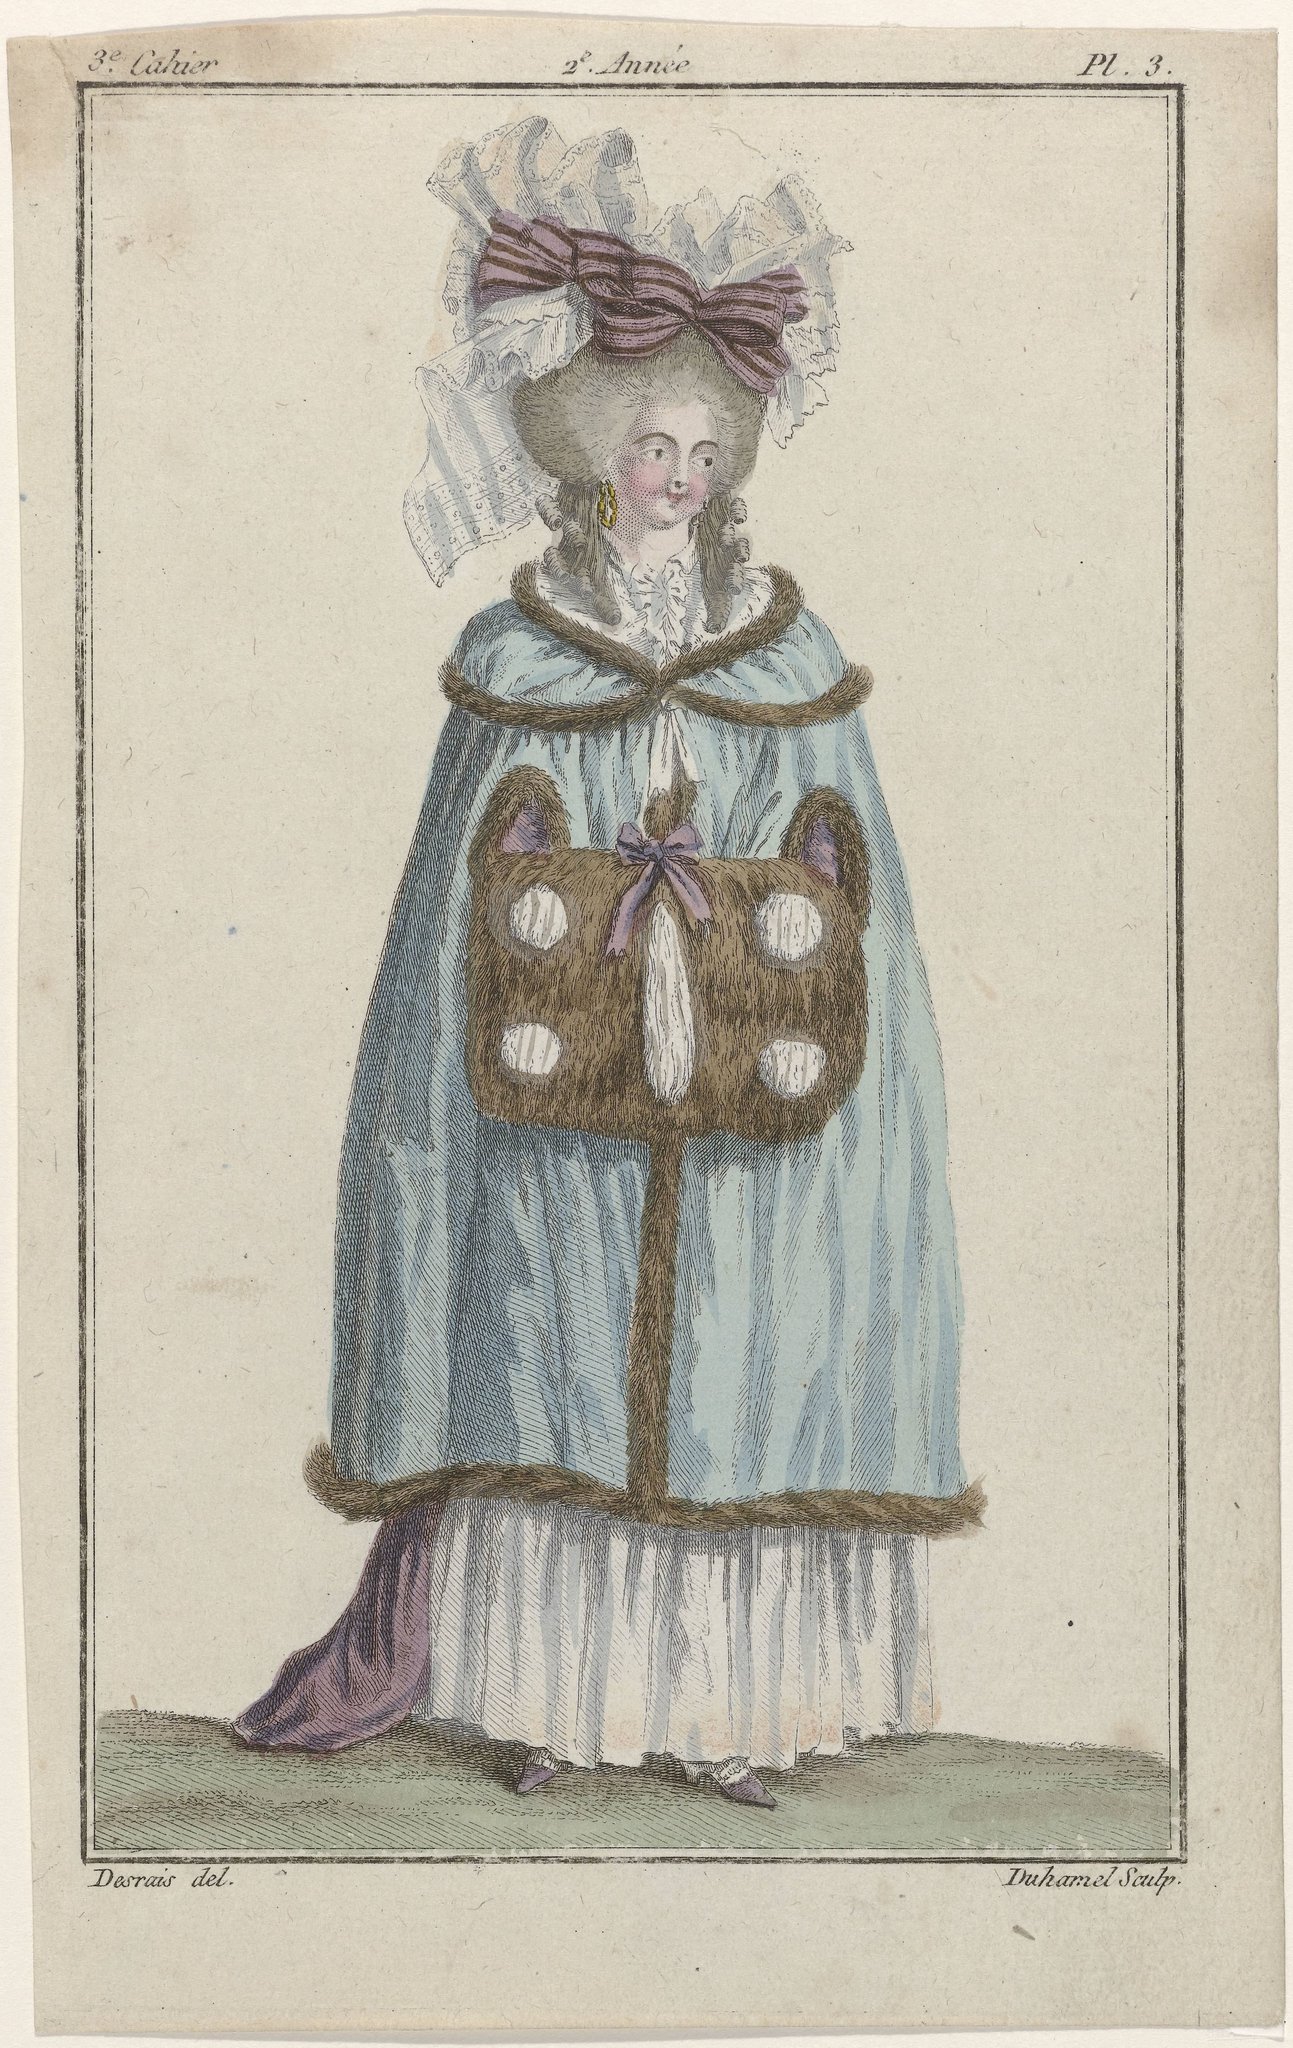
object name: fashion print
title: Magasin des Modes Nouvelles Françaises et Anglaises, 10 décembre 1786, 2e Année, 3e cahier, Pl. 3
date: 1786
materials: paper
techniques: engraving, hand coloring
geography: paris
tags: ear-rings (+ women's clothes), cape (pelisse) (+ women's clothes), head-gear: cap (+ women's clothes), fashion plates, shoes, sandals (+ women's clothes), skirt (+ women's clothes), muff (+ fur used for clothes), piece of clothing covering the breast or décolleté (fichu) (+ women's clothes)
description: Staande vrouw gekleed in een pelisse van blauw satijn, afgezet met bont. Hieronder draagt zij een fichu(?), japon met sleep en een rok. De handen in een mof van vossenbont, versierd met strik. Verdere accessoires: muts versierd met breed gestreept lint, oorbellen, schoenen met hakken. De prent maakt deel uit van het 2e Année, 3e Cahier, uit de serie Magasin des Modes Nouvelles Françaises et Anglaises. De serie bestaat uit 172 modeprenten, uitgegeven door Buisson, Parijs, 20 novembre 1786 - 21 décembre 1789.